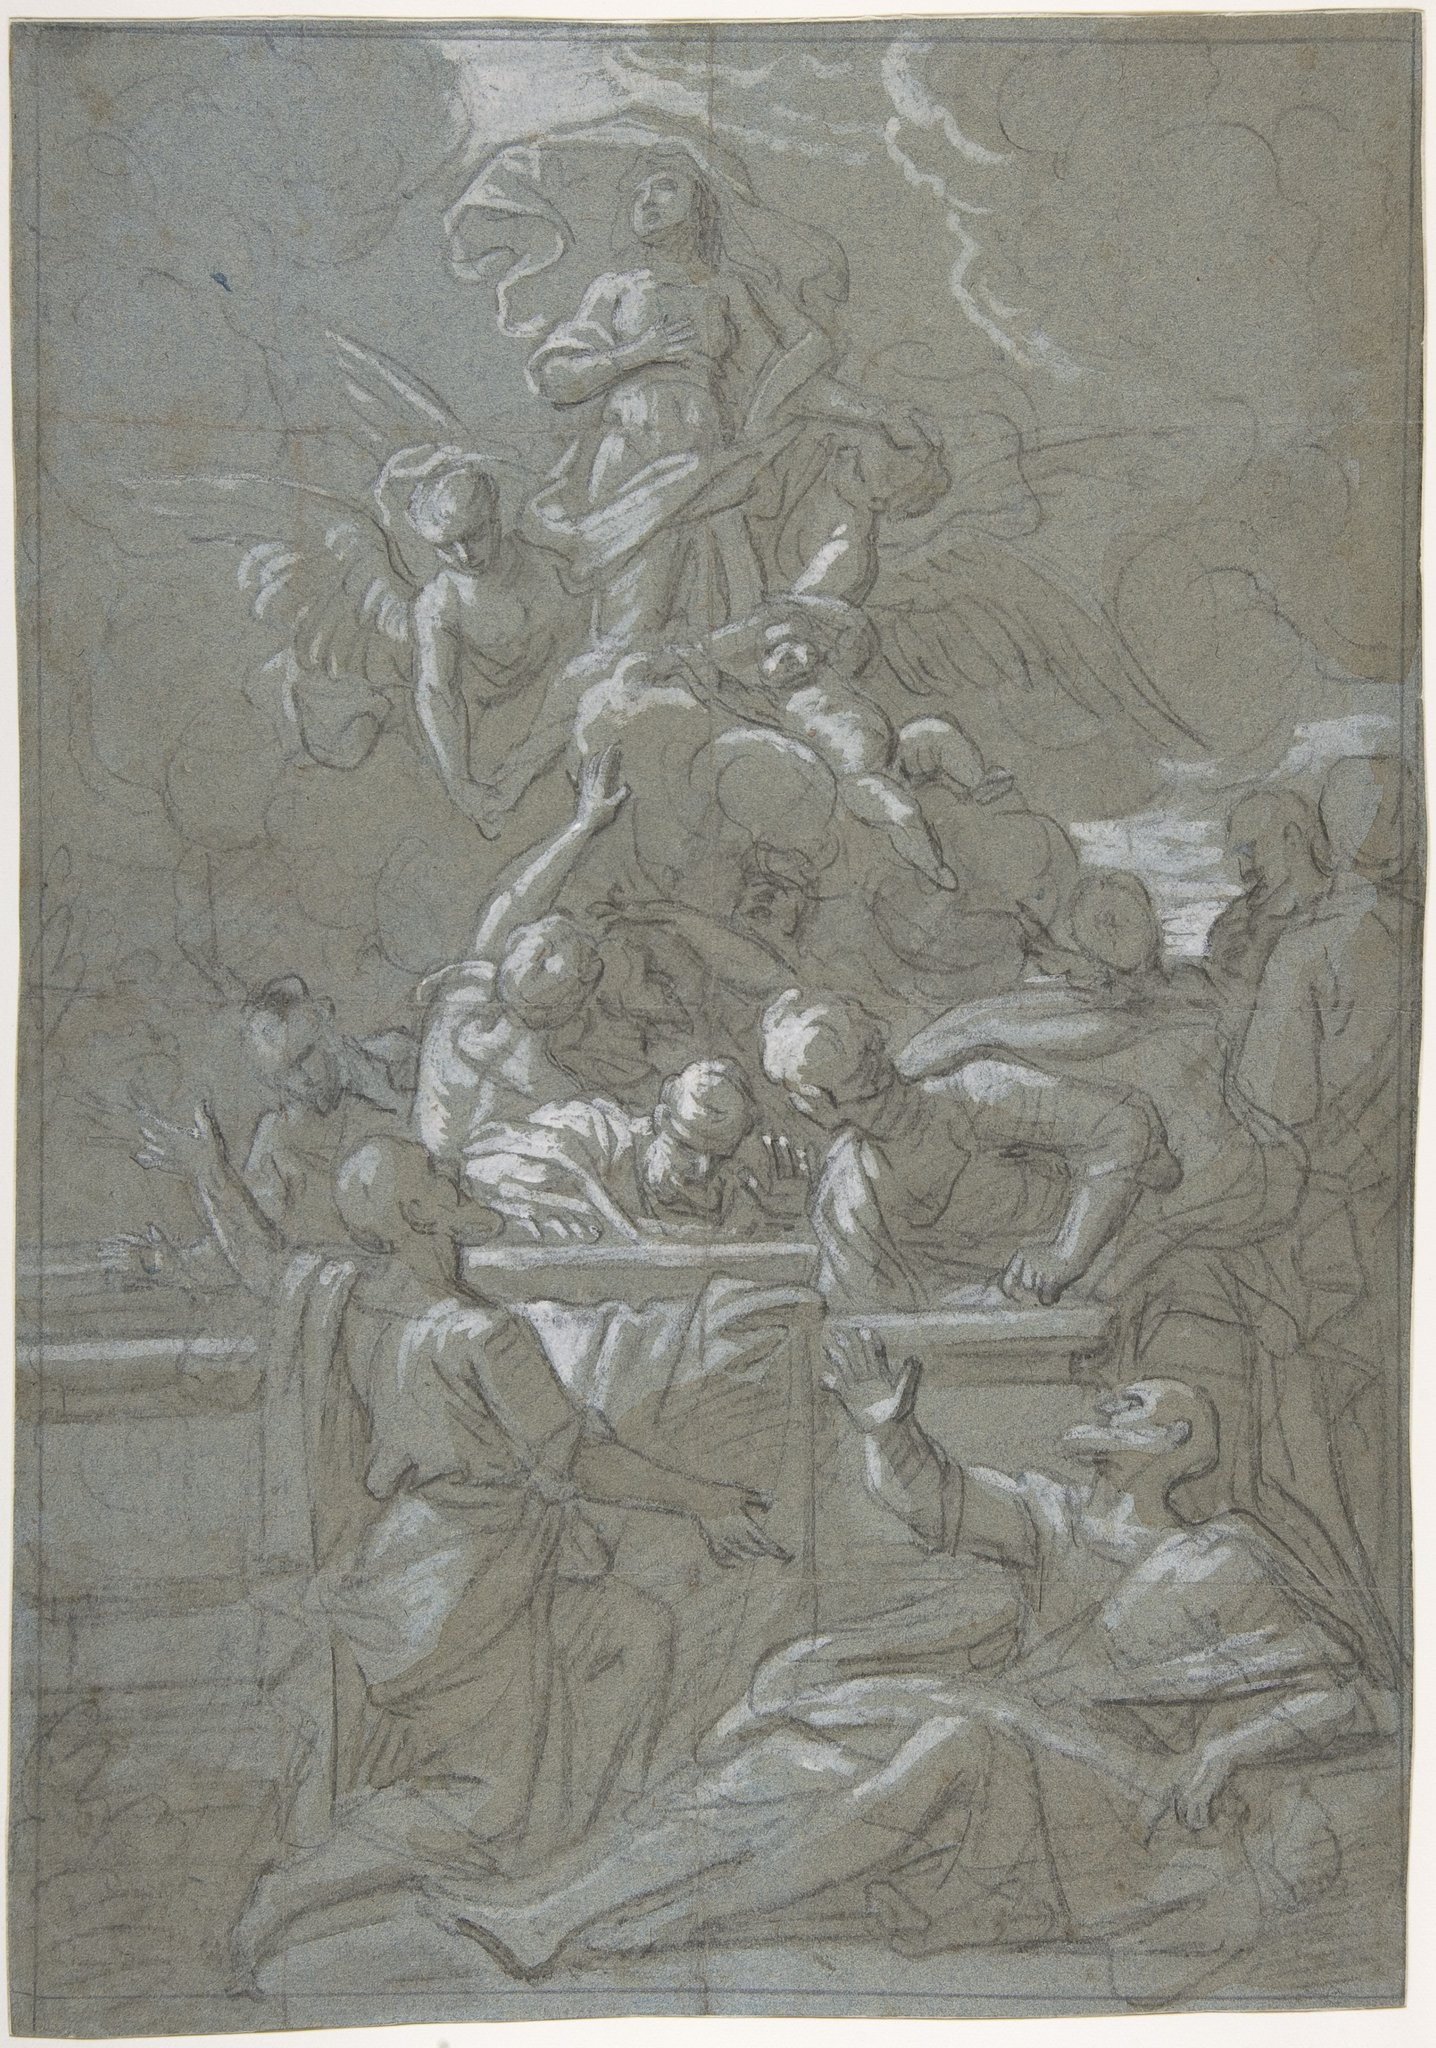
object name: drawing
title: The Assumption of the Virgin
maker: jean-baptiste jouvenet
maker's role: artist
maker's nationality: french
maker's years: 1644-1717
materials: chalk, paper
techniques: heightening, wash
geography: france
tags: men,angels,virgin mary,assumption of the virgin